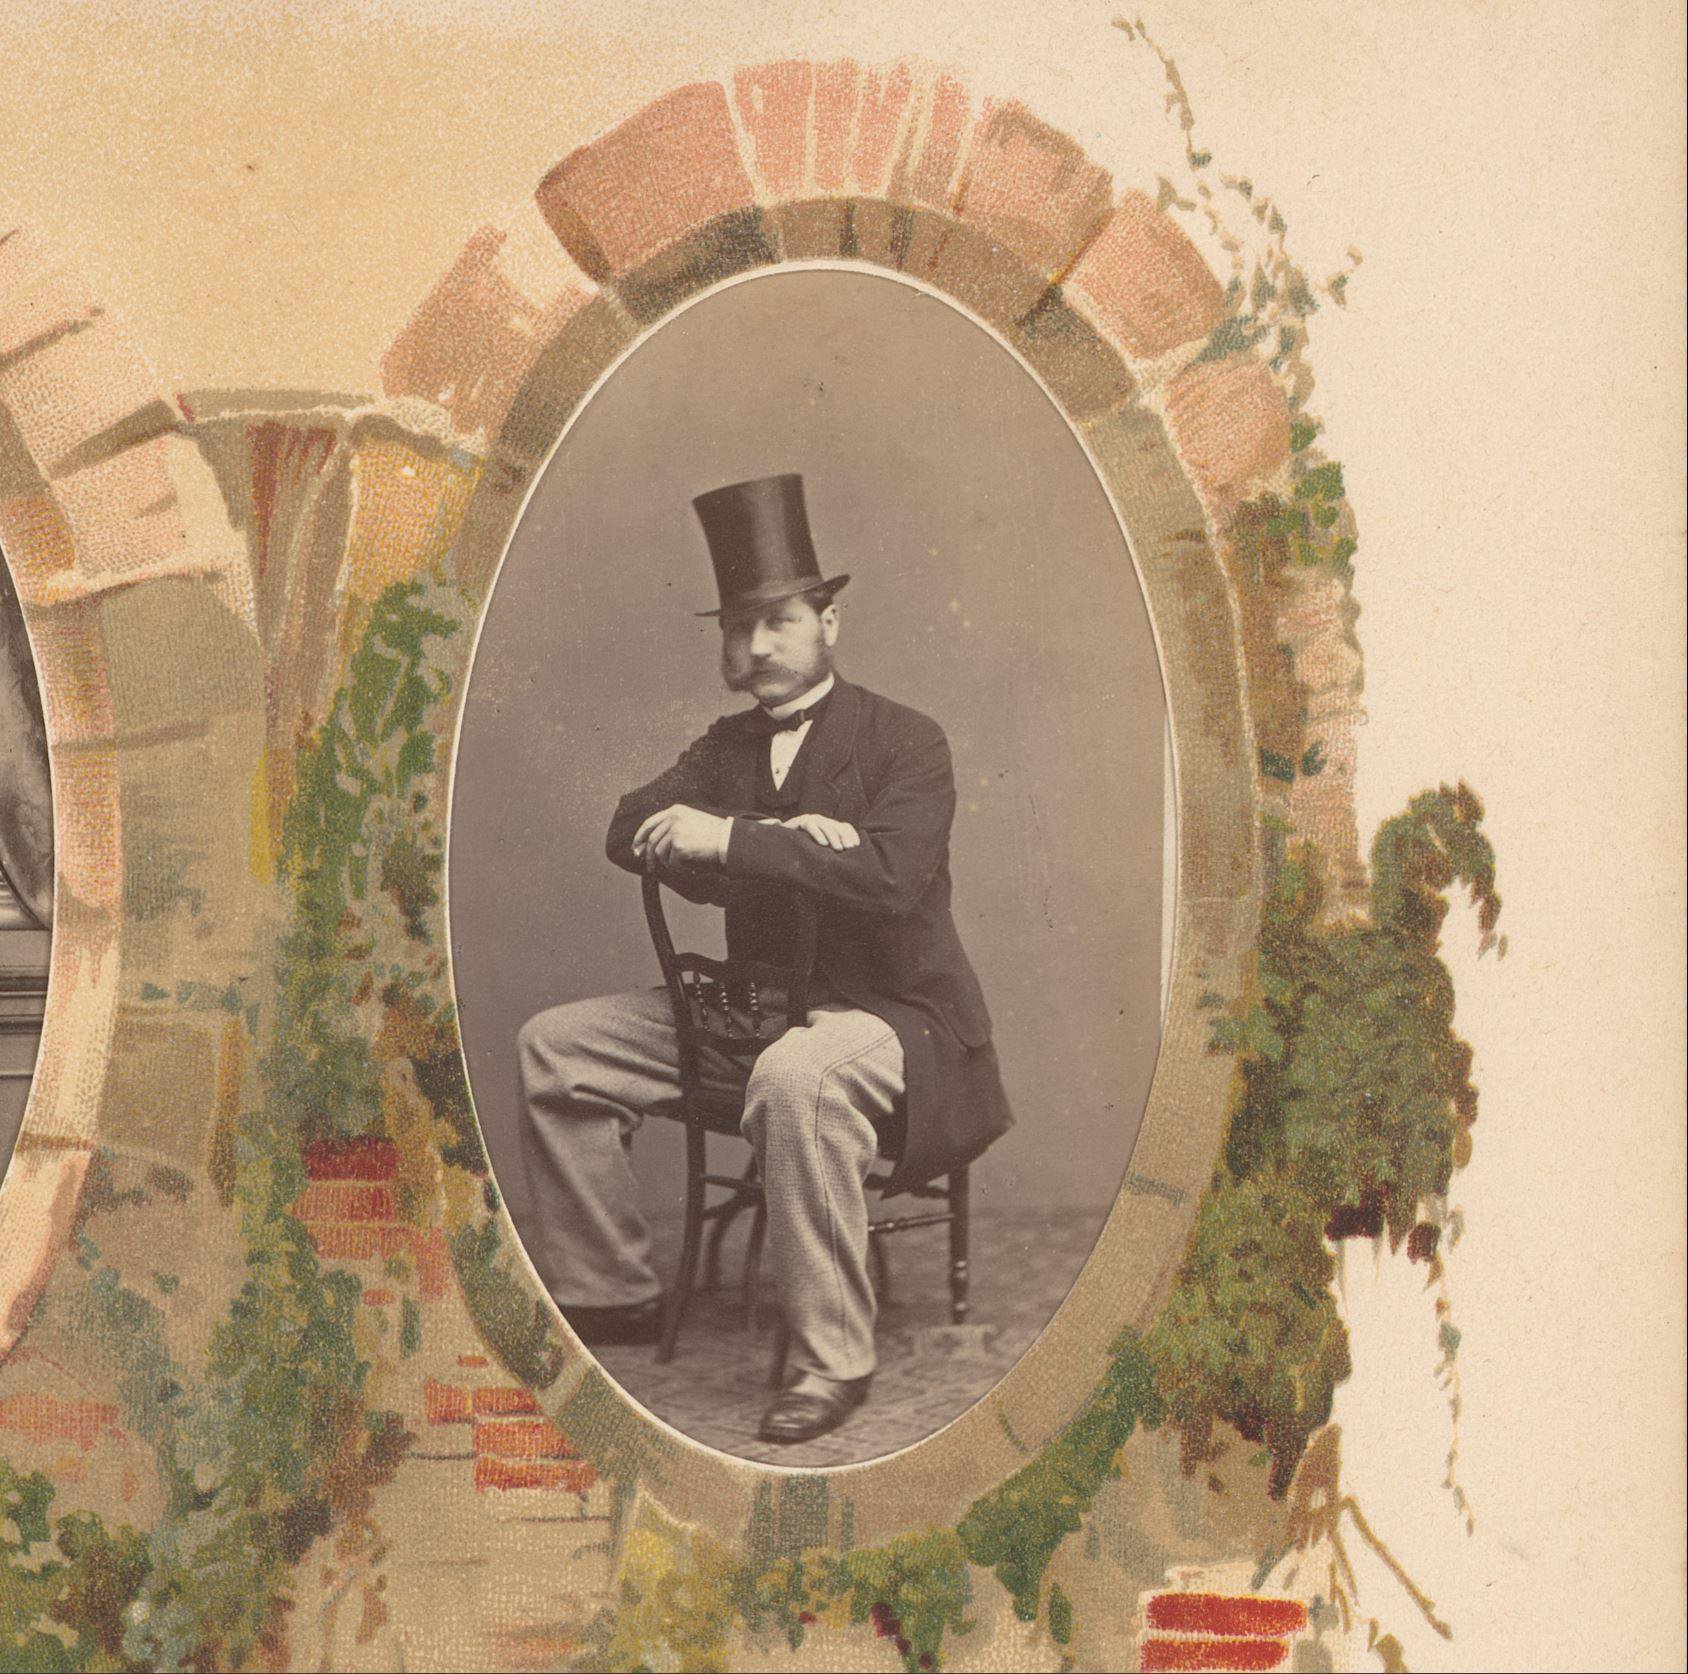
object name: photograph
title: Portret van een man met hoed, zittend op een stoel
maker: friedrich hundt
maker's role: fotograaf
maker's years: 1807-1887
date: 1850-1900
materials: cardboard, photographic support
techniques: albumen print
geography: munster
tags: historical persons, chair, head-gear: top hat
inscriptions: annotation: ‘Aug. Buchholz/ ([...]ir [.]ase)’, inscription: ‘Photographisches Atelier/ F. HUNDT. Kreuzstrasse 96/ MÜNSTER/ Westfalen.’